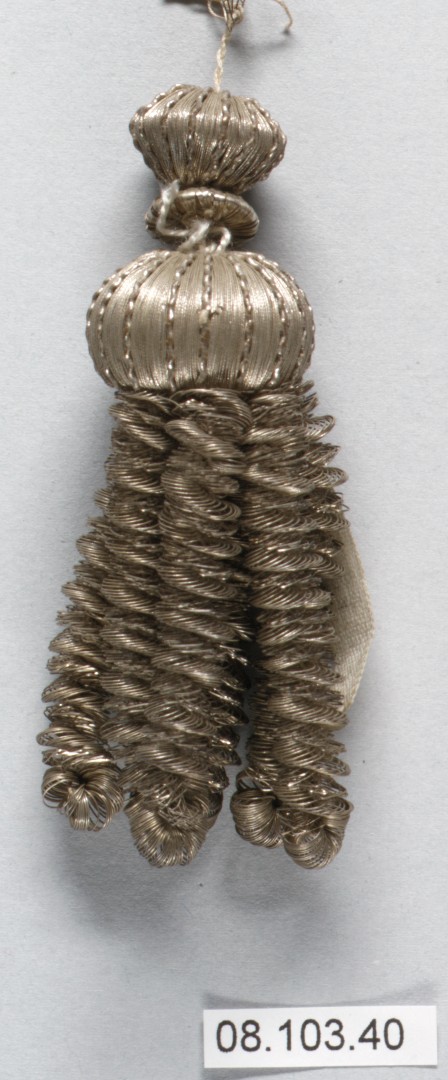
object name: tassel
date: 1801-1833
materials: metal thread